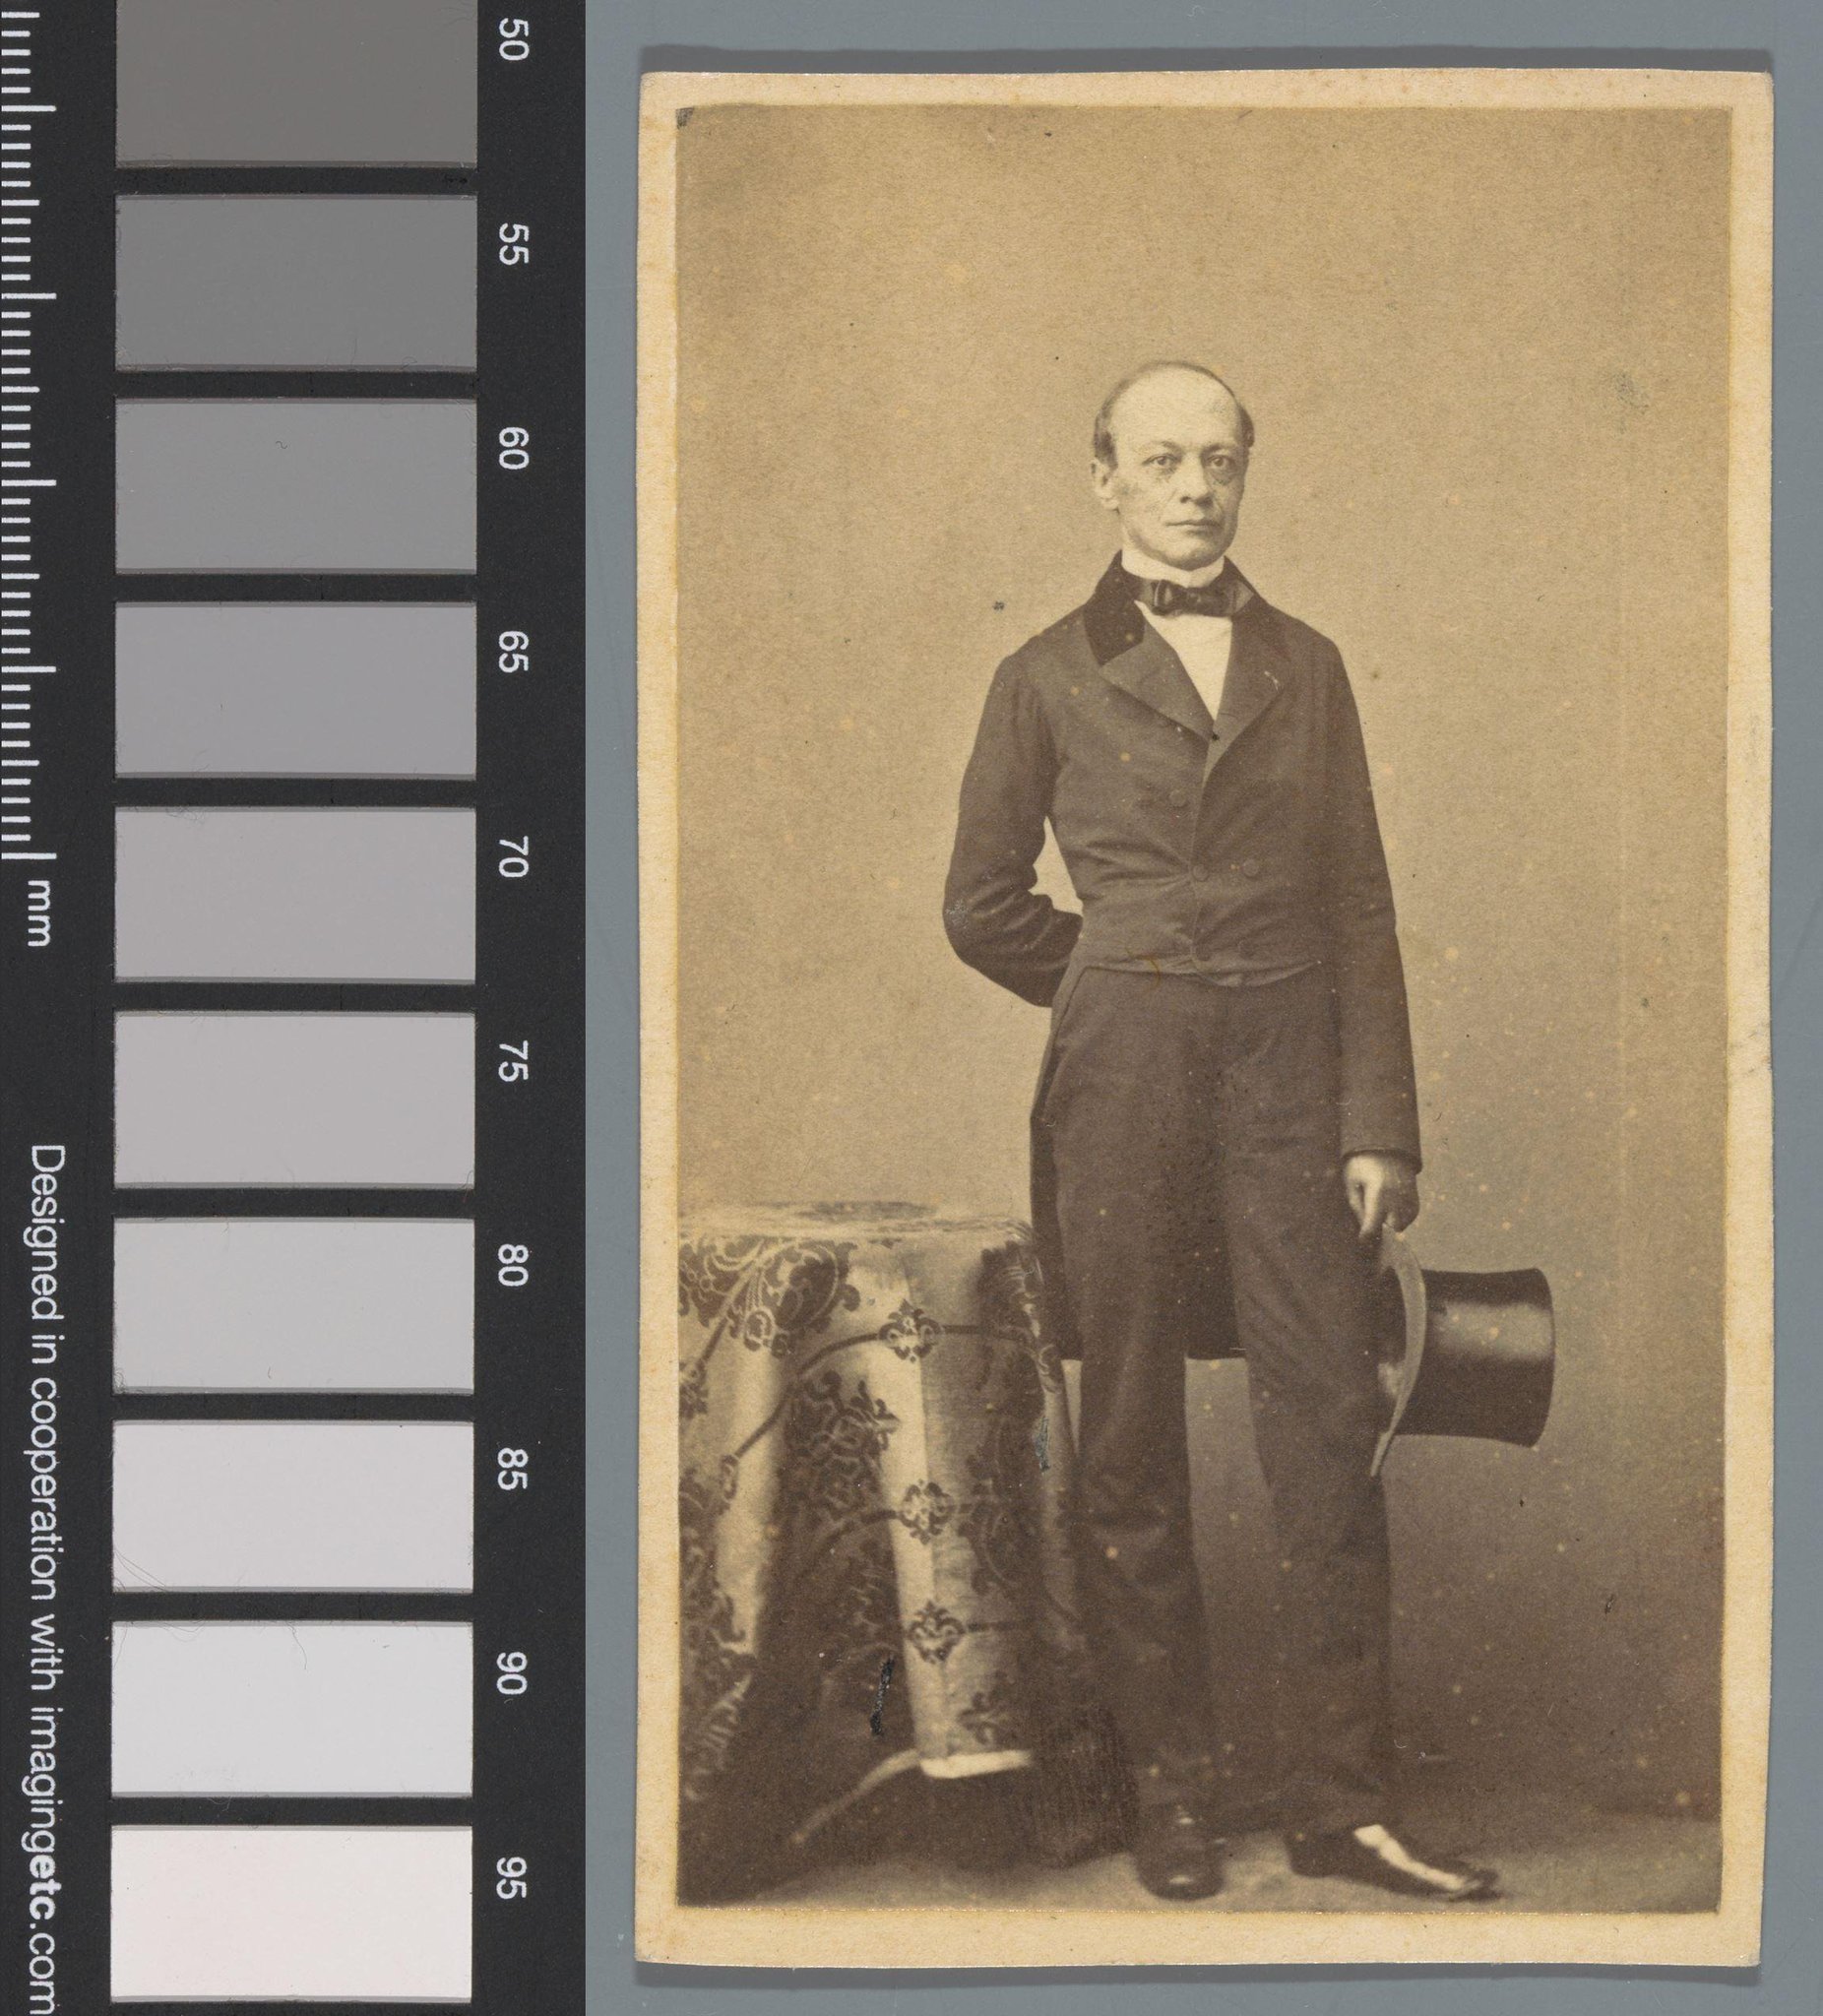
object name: photograph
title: Portret van een onbekende man met hoge hoed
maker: choedotsink g. denor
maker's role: fotograaf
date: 1855-1885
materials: cardboard, paper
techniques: albumen print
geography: sint-petersburg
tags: adult man, anonymous historical person portrayed, head-gear: top hat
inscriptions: inscription: ‘[...]’